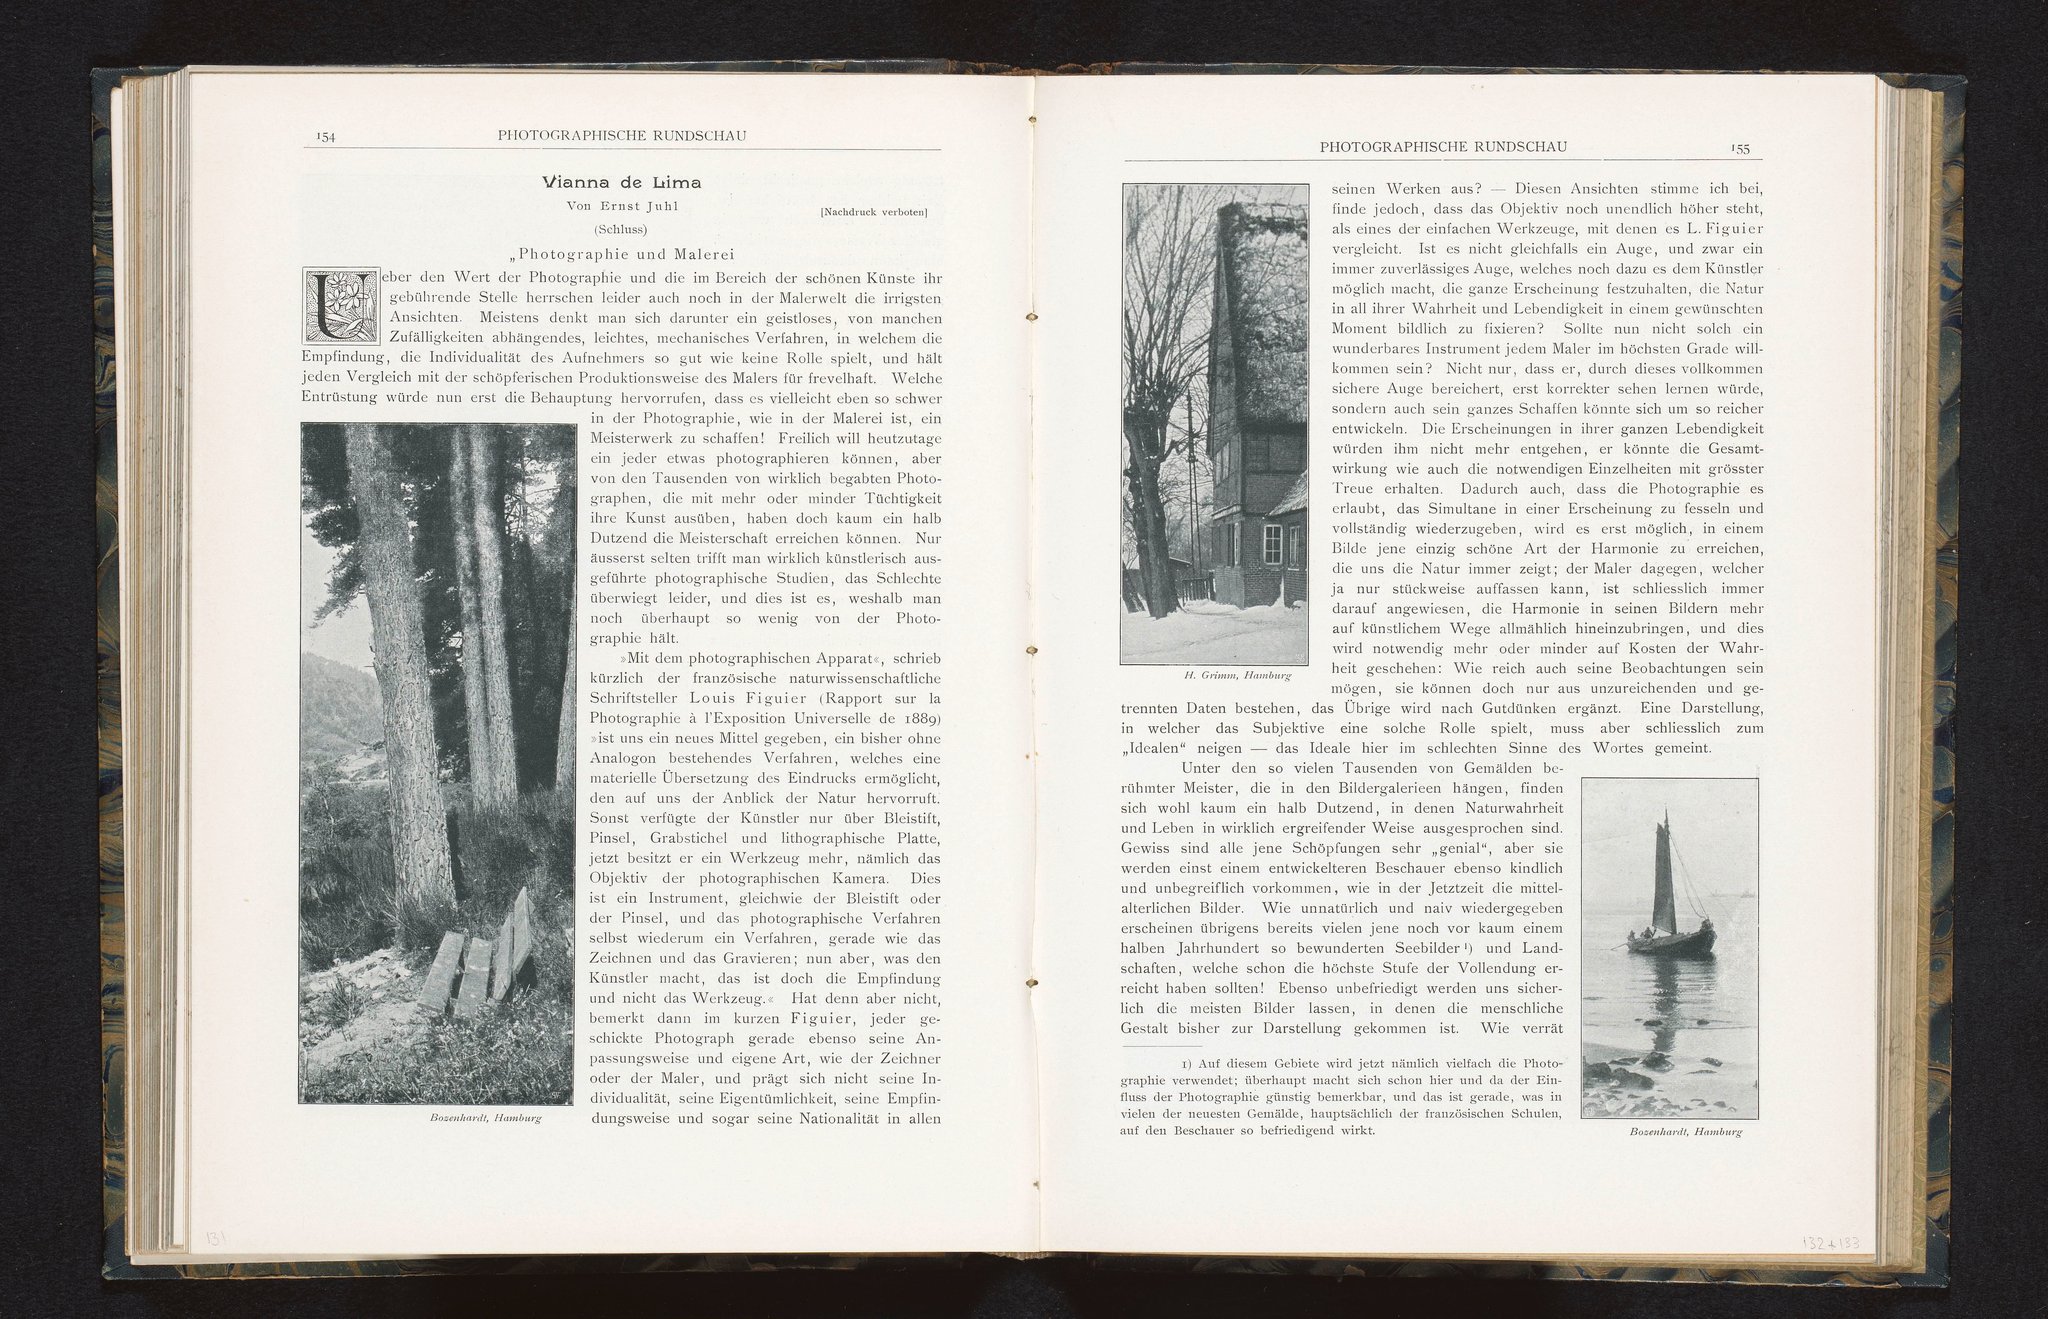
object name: photomechanical print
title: Gezicht op een zeilboot te water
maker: o. bozenhardt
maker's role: fotograaf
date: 1895-1900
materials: paper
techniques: autotype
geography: berlin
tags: sailing-ship, sailing-boat, landscapes with waters, waterscapes, seascapes (in the temperate zone)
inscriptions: monogram: ‘MR/&Co’